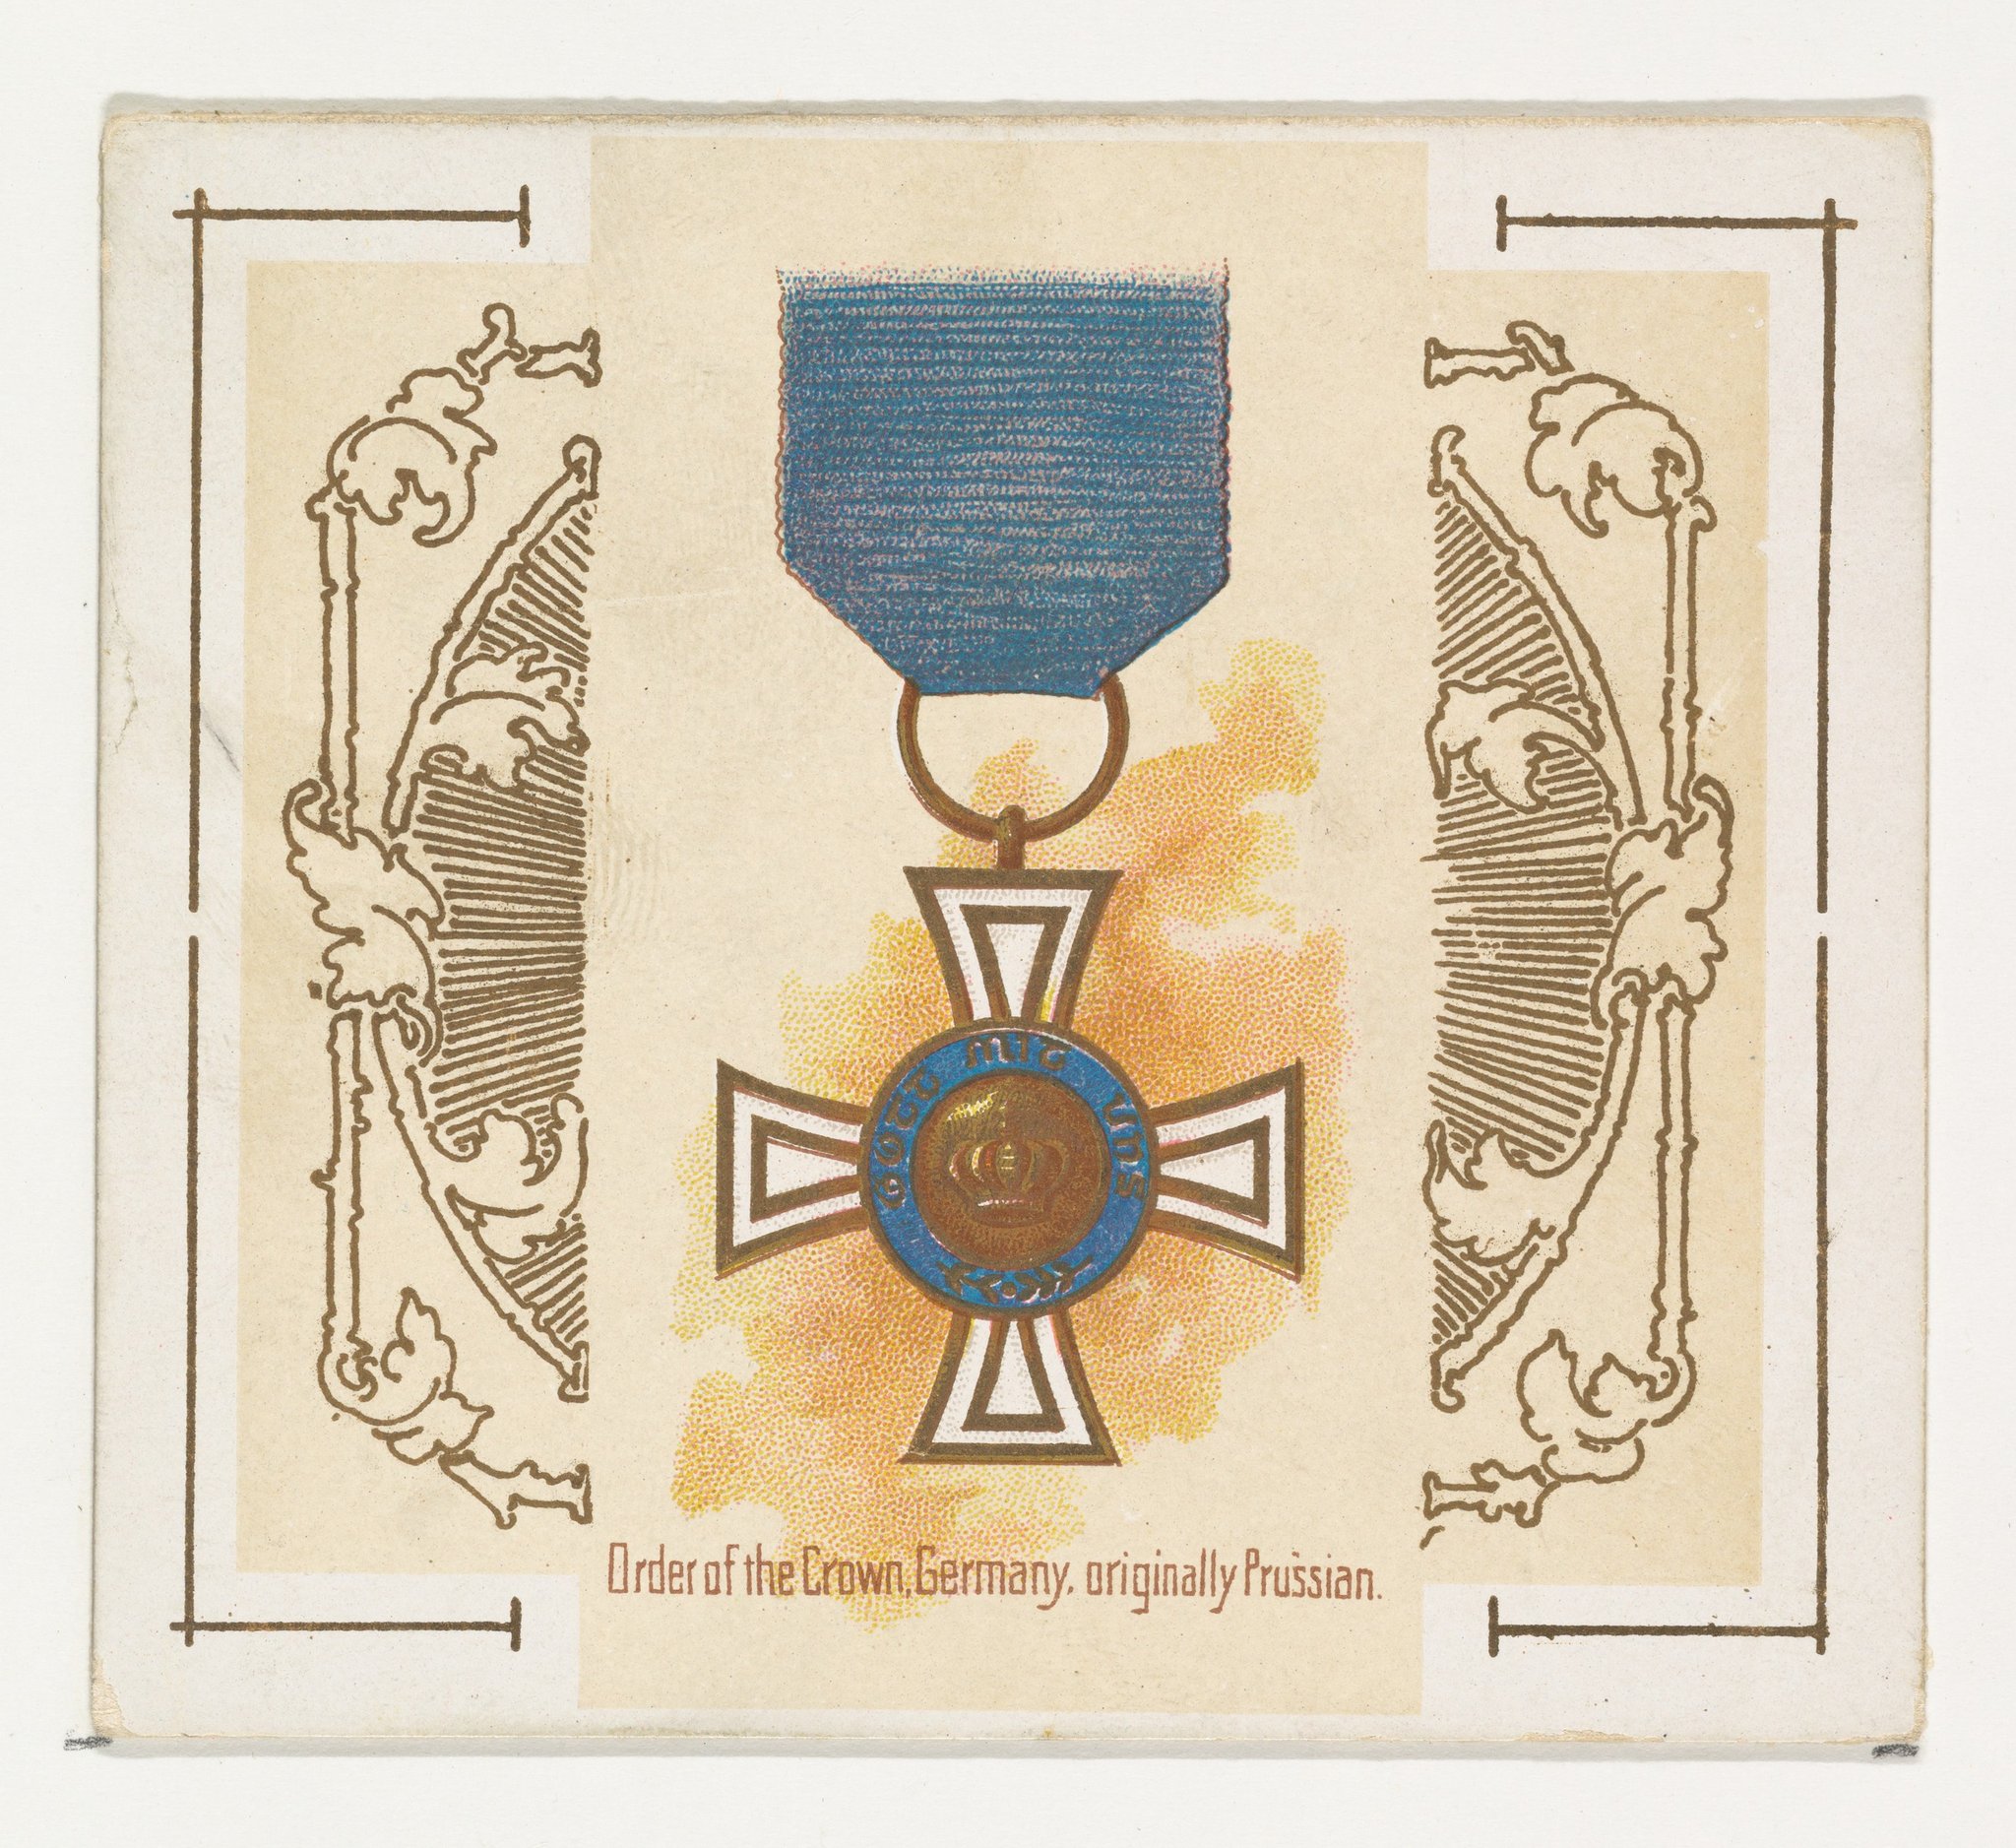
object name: print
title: Order of the Crown, Germany, originally Prussian, from the World's Decorations series (N44) for Allen & Ginter Cigarettes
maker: allen & ginter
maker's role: publisher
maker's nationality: american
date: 1890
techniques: color lithograph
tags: medals